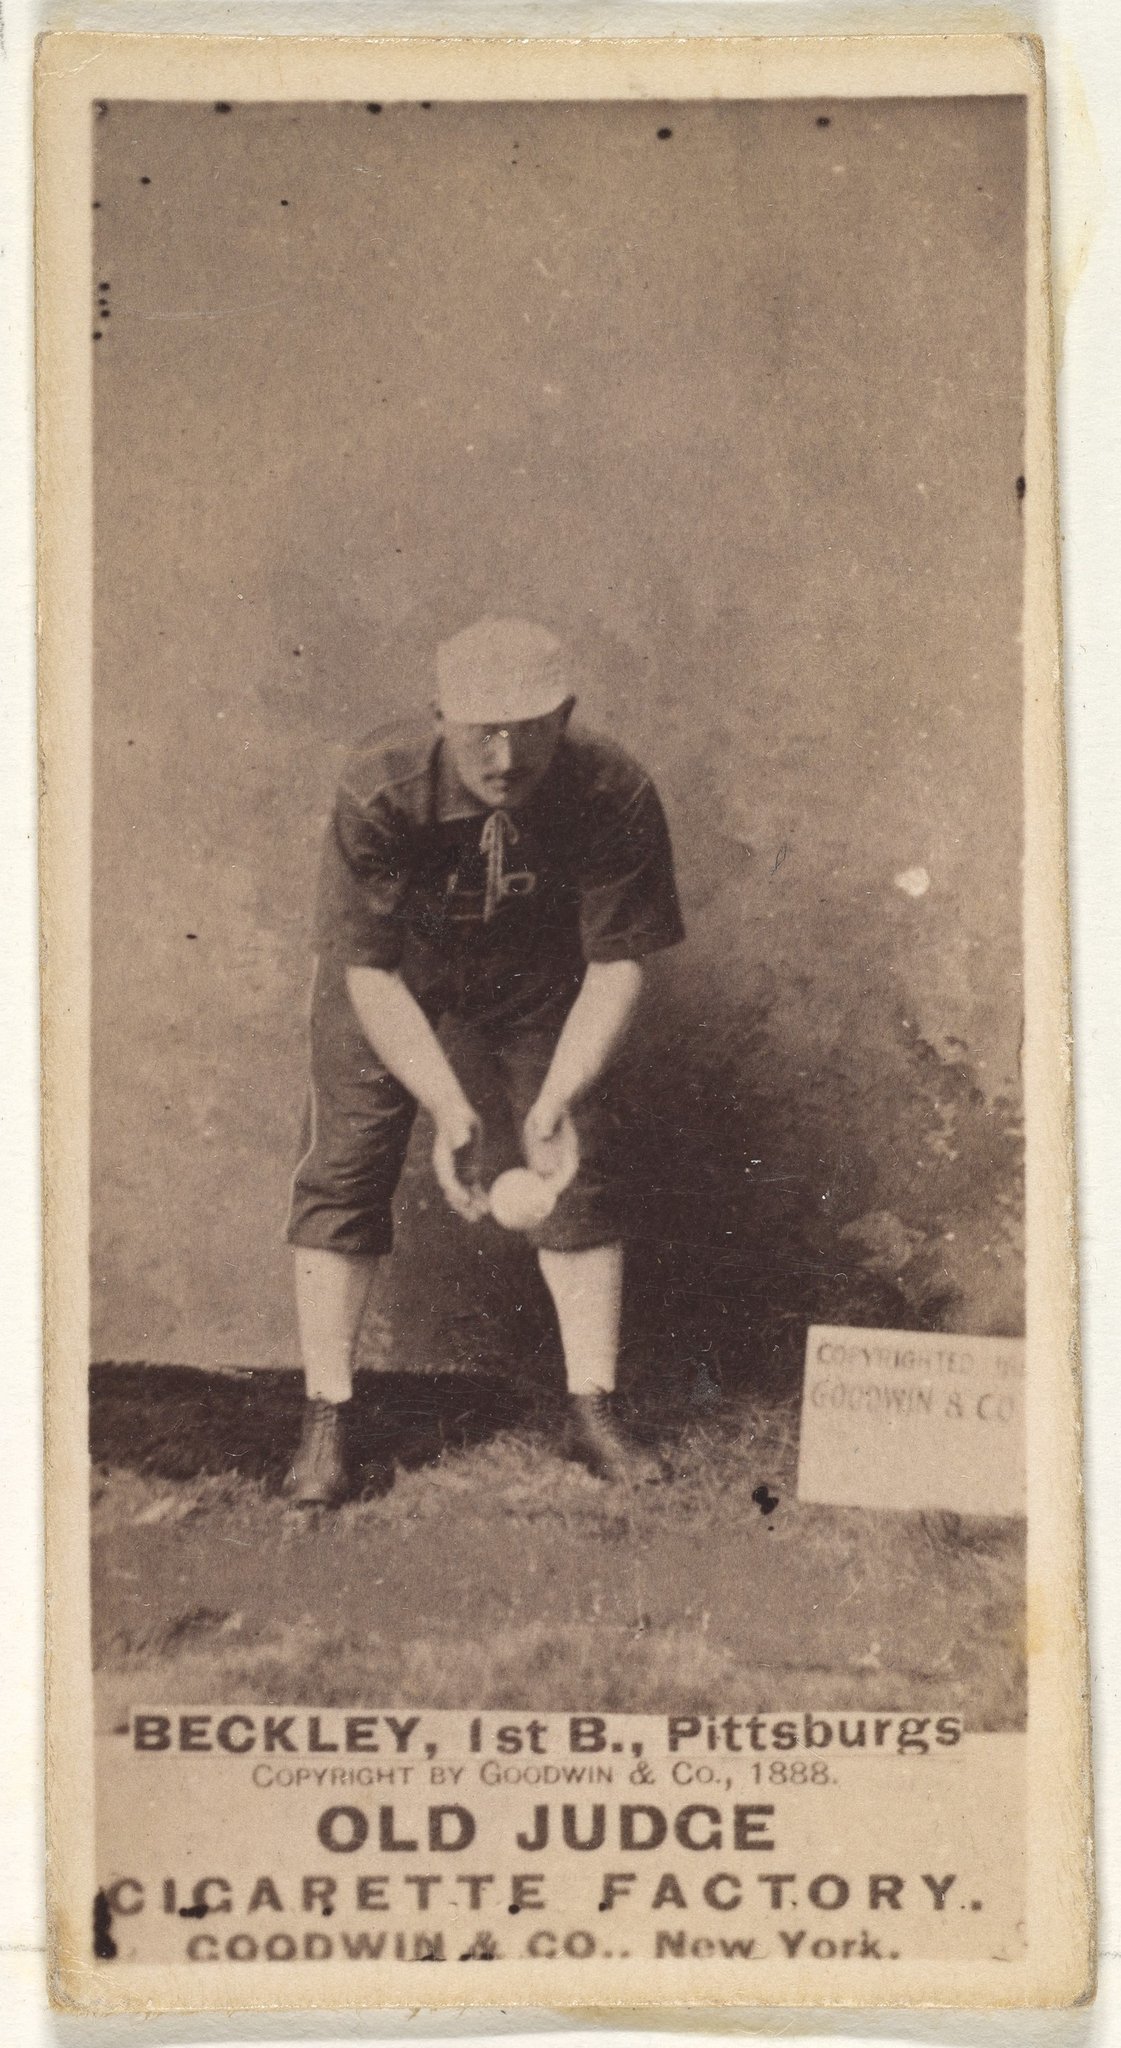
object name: baseball card, photograph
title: Jacob Peter "Eagle Eye" Beckley, 1st Base, Pittsburgh, from the Old Judge series (N172) for Old Judge Cigarettes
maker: goodwin & company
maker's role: publisher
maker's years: 1850-1950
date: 1888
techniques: albumen silver print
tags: men,portraits,baseball,athletes